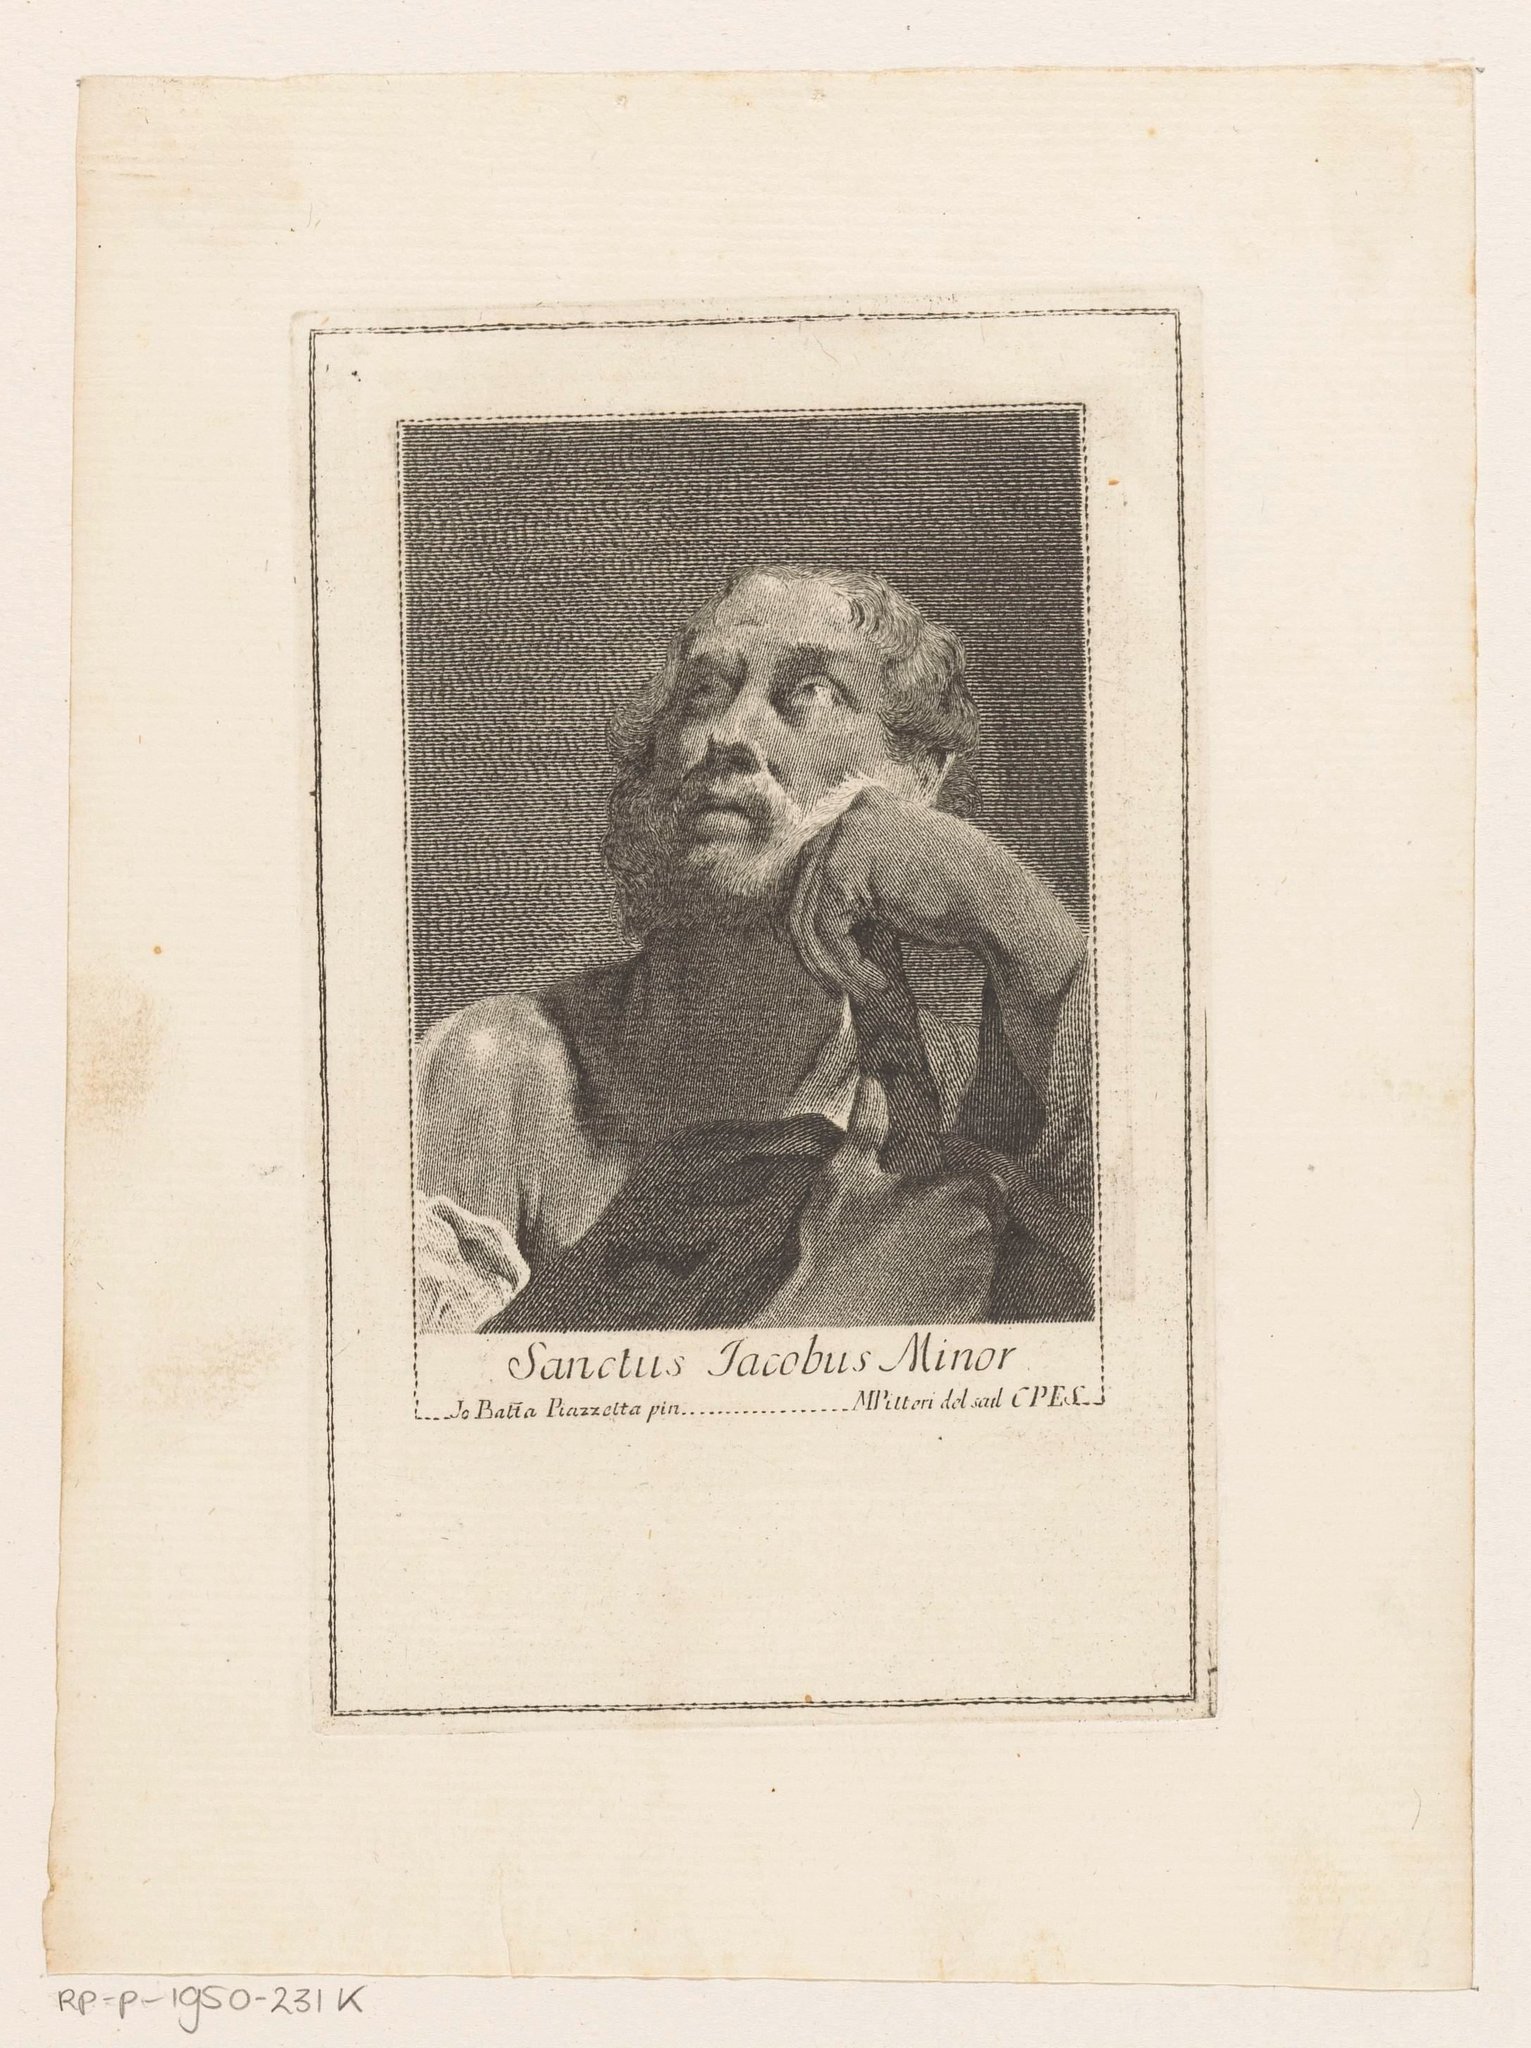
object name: print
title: Apostel Jakobus de Mindere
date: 1712-1786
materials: paper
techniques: engraving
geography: venice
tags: the apostle james the less, first bishop of jerusalem; possible attributes: book, fuller's club, scroll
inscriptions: collector's mark: Lugt 2228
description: In de literatuur worden alleen de twaalf apostelen samen als serie geteld. Maar uit de collectie van het Rijksmuseum kunnen we opmaken dat de serie uit ten minste 19 prenten en een titelprent bestond.